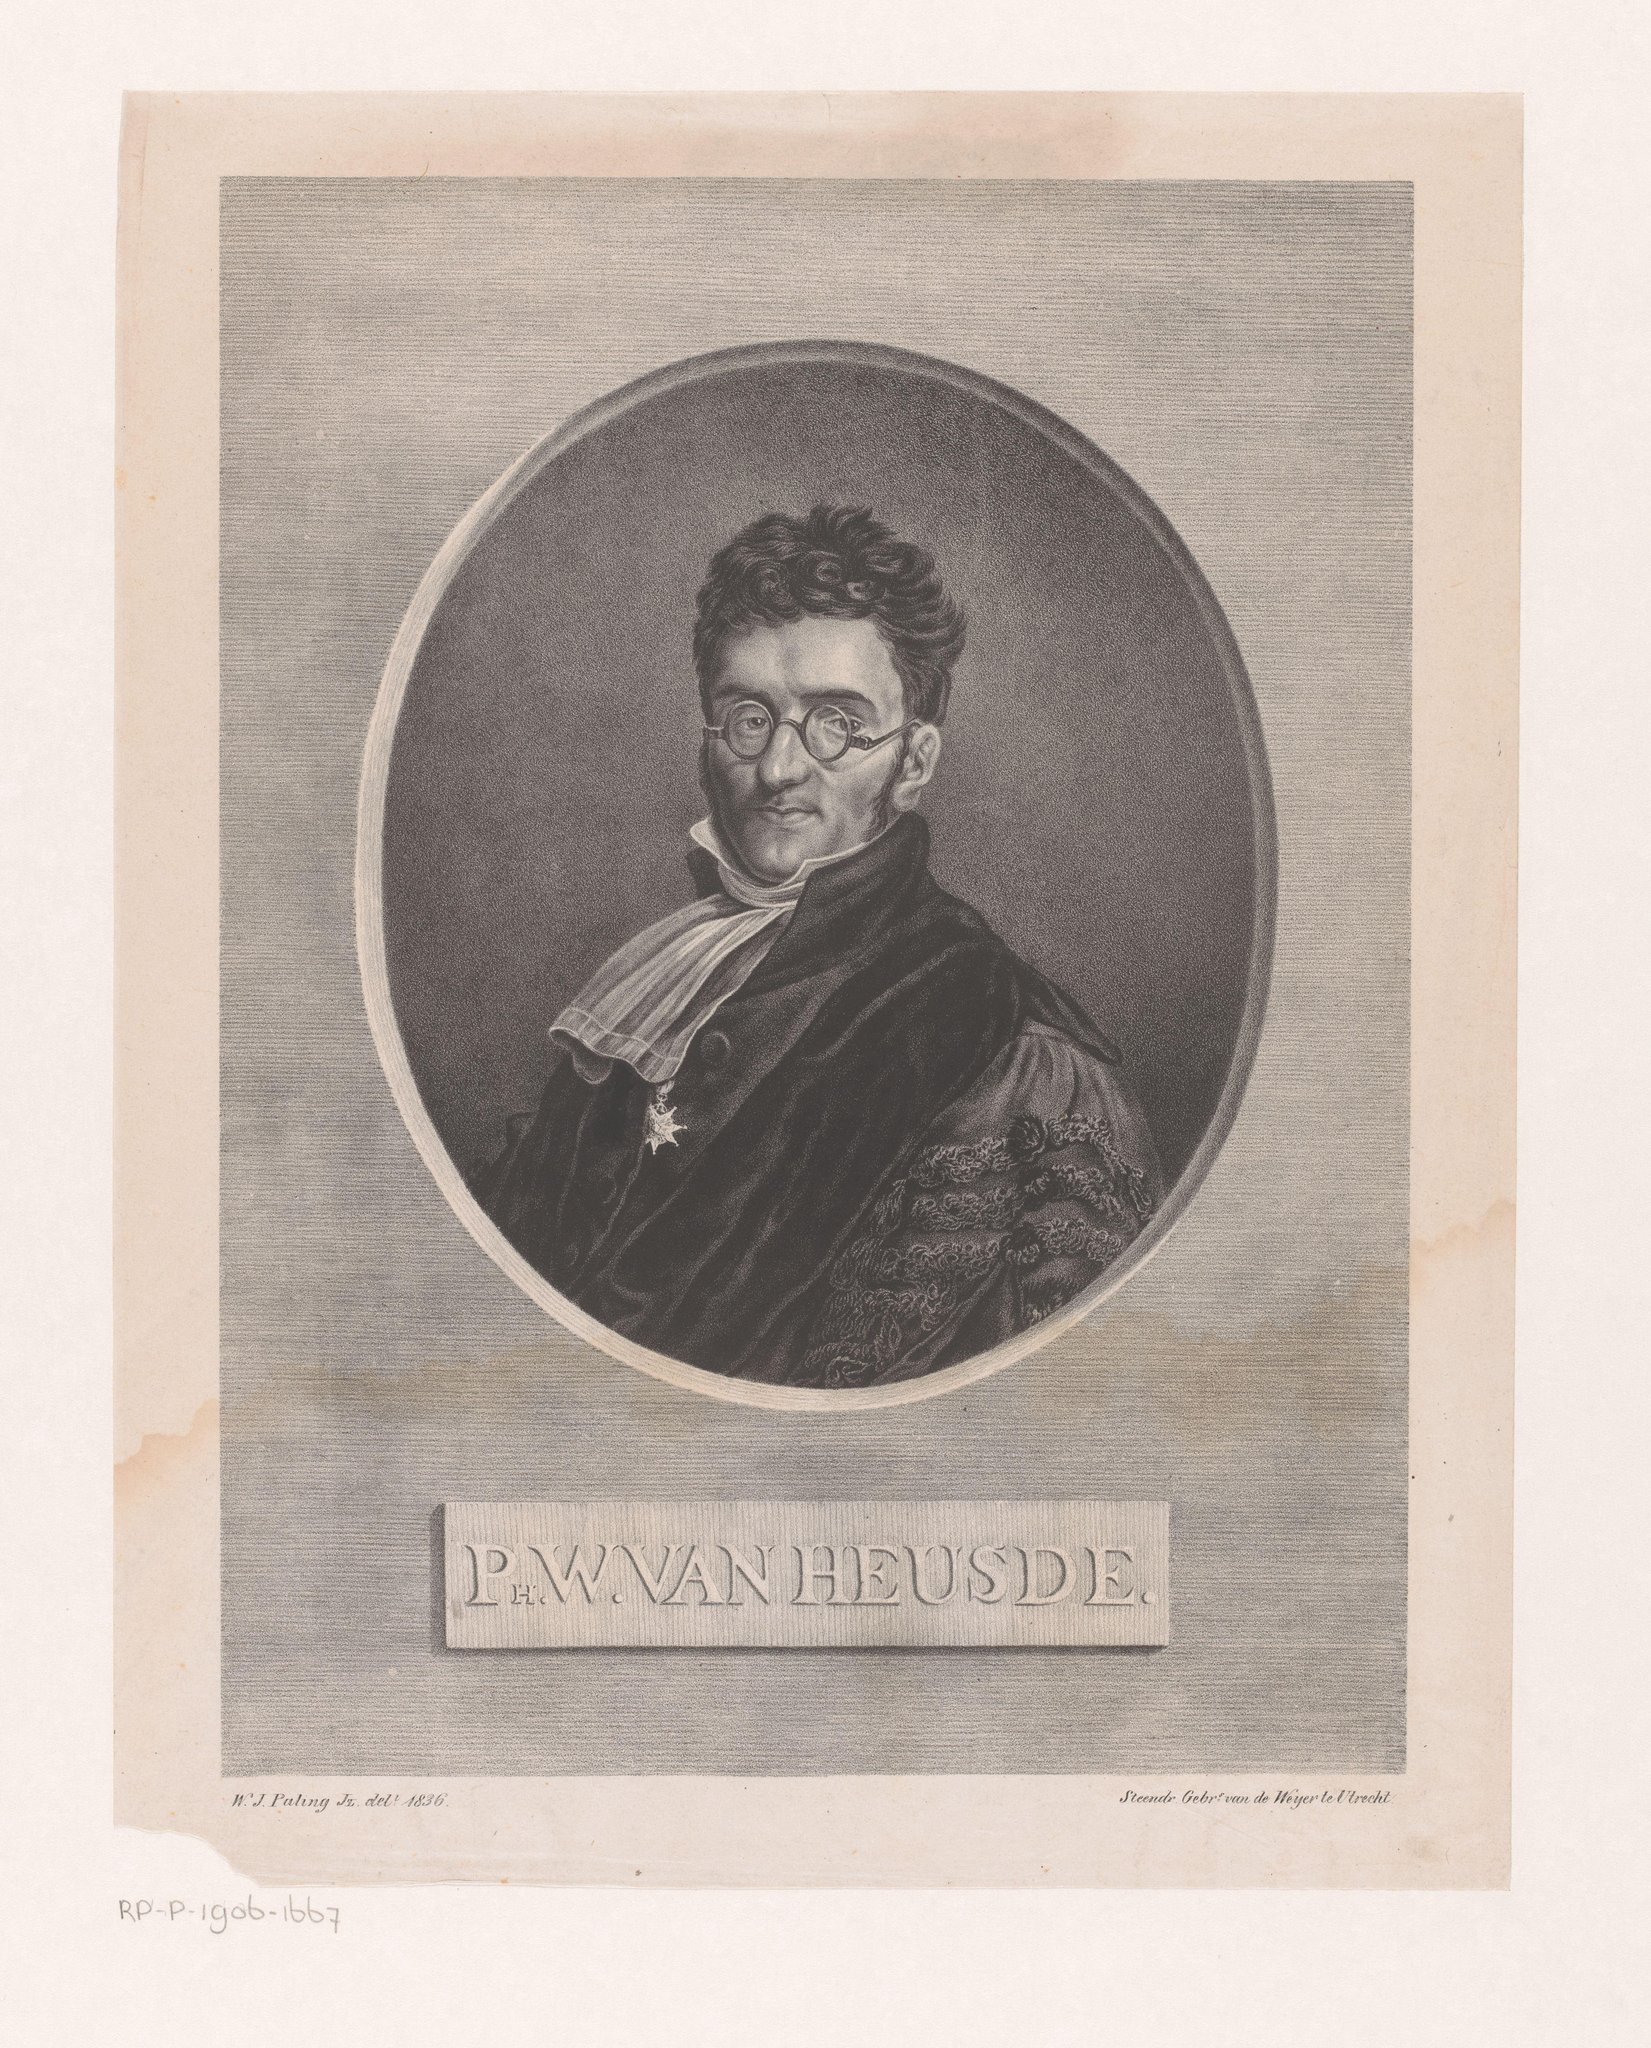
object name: print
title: Portret van Philip Willem van Heusde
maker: willem jan paling jz.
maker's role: print maker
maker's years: 1776-1848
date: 1836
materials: paper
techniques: lithograph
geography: utrecht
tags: rotterdam, historical persons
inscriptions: collector's mark: Lugt 2228